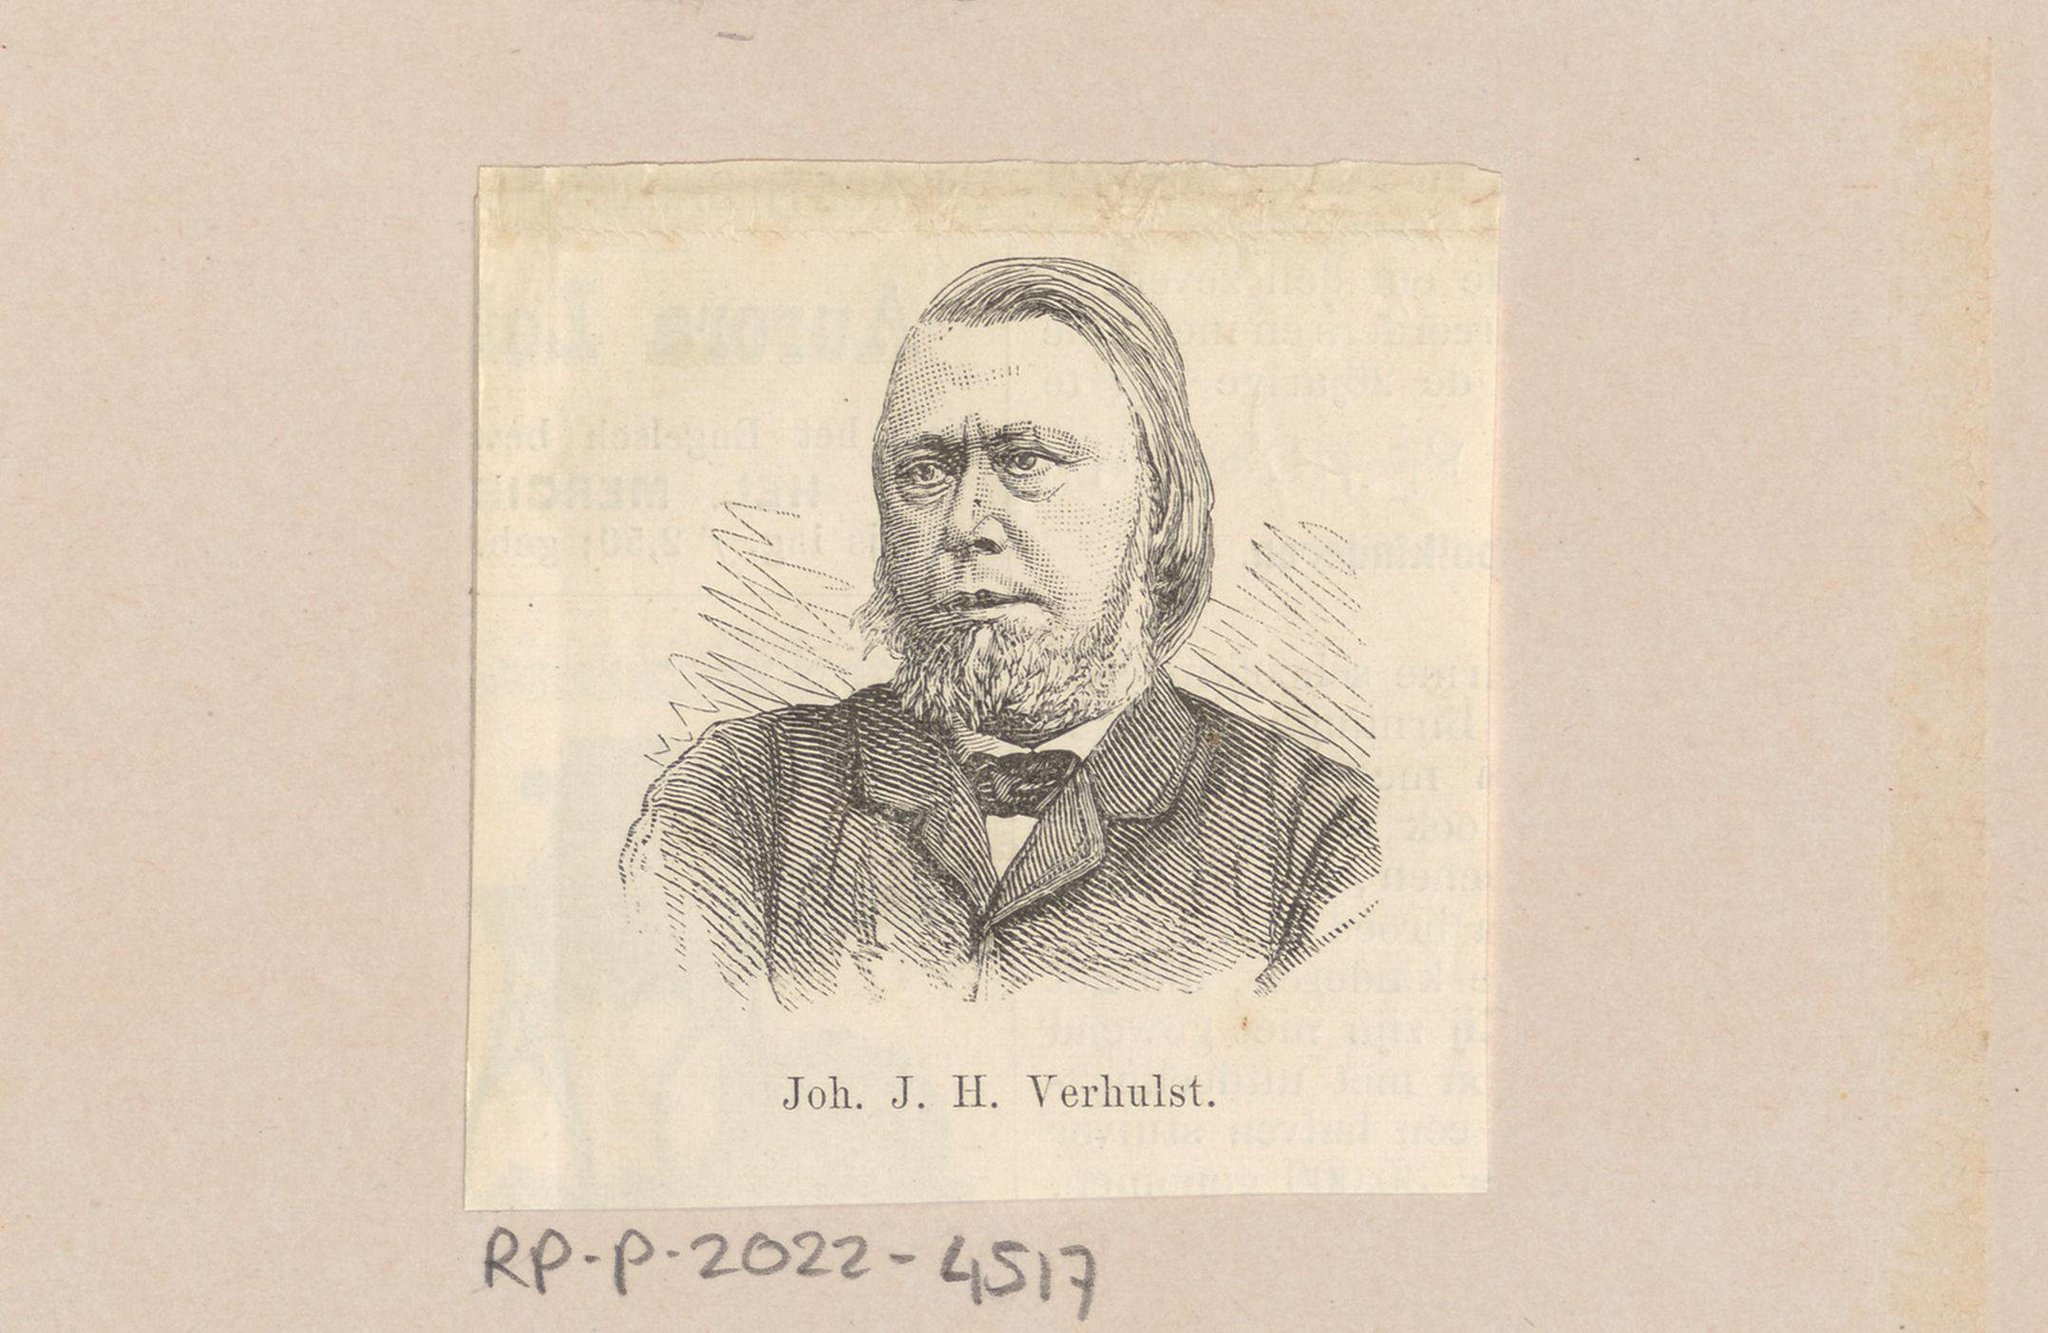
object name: print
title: Portret van Johannes Josephus Herman Verhulst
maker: Anonymous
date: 1870-1900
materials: paper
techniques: letterpress printing, engraving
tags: the hague, johannes verhulst, historical persons, portrait of composer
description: Prent komt uit een onbekende publicatie.